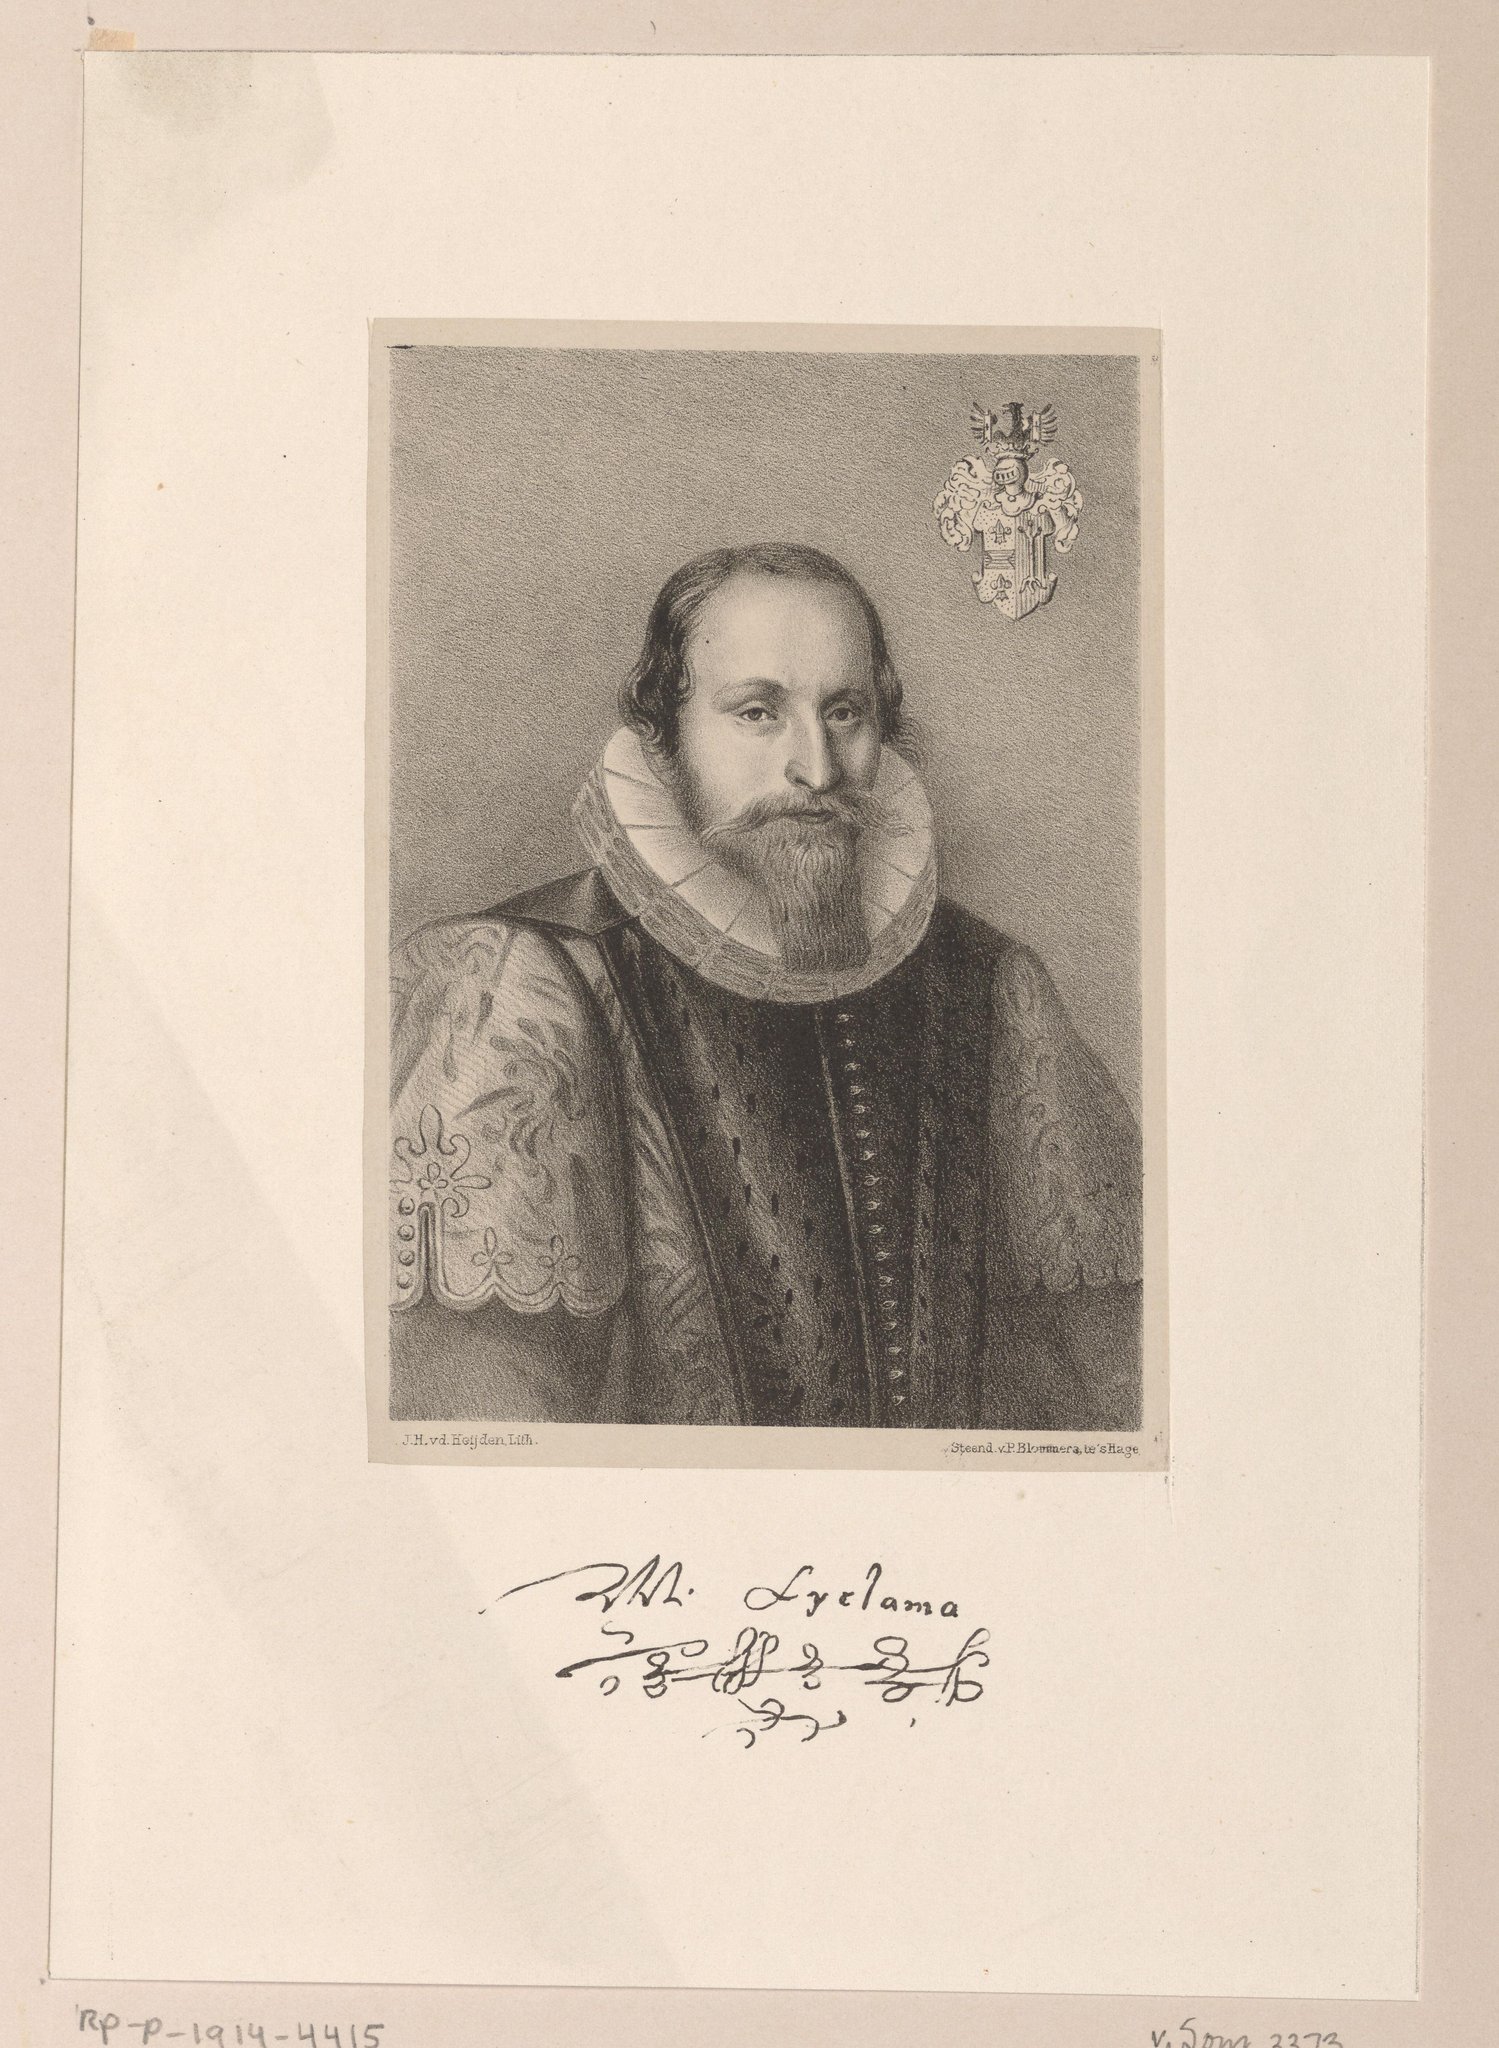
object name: print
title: Portret van Marcus Lycklama à Nijeholt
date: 1889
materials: paper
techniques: lithograph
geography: the hague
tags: historical persons, armorial bearing, heraldry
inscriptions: collector's mark: Lugt 2228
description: Prent waarschijnlijk uit: Boeles, Willem Boele Sophius. Frieslands Hoogeschool en het Rijks Athenaeum te Franeker. Leeuwarden: Fries Genootschap van Geschied-, Oudheid- en Taalkunde, 1889, dl. 2-2.